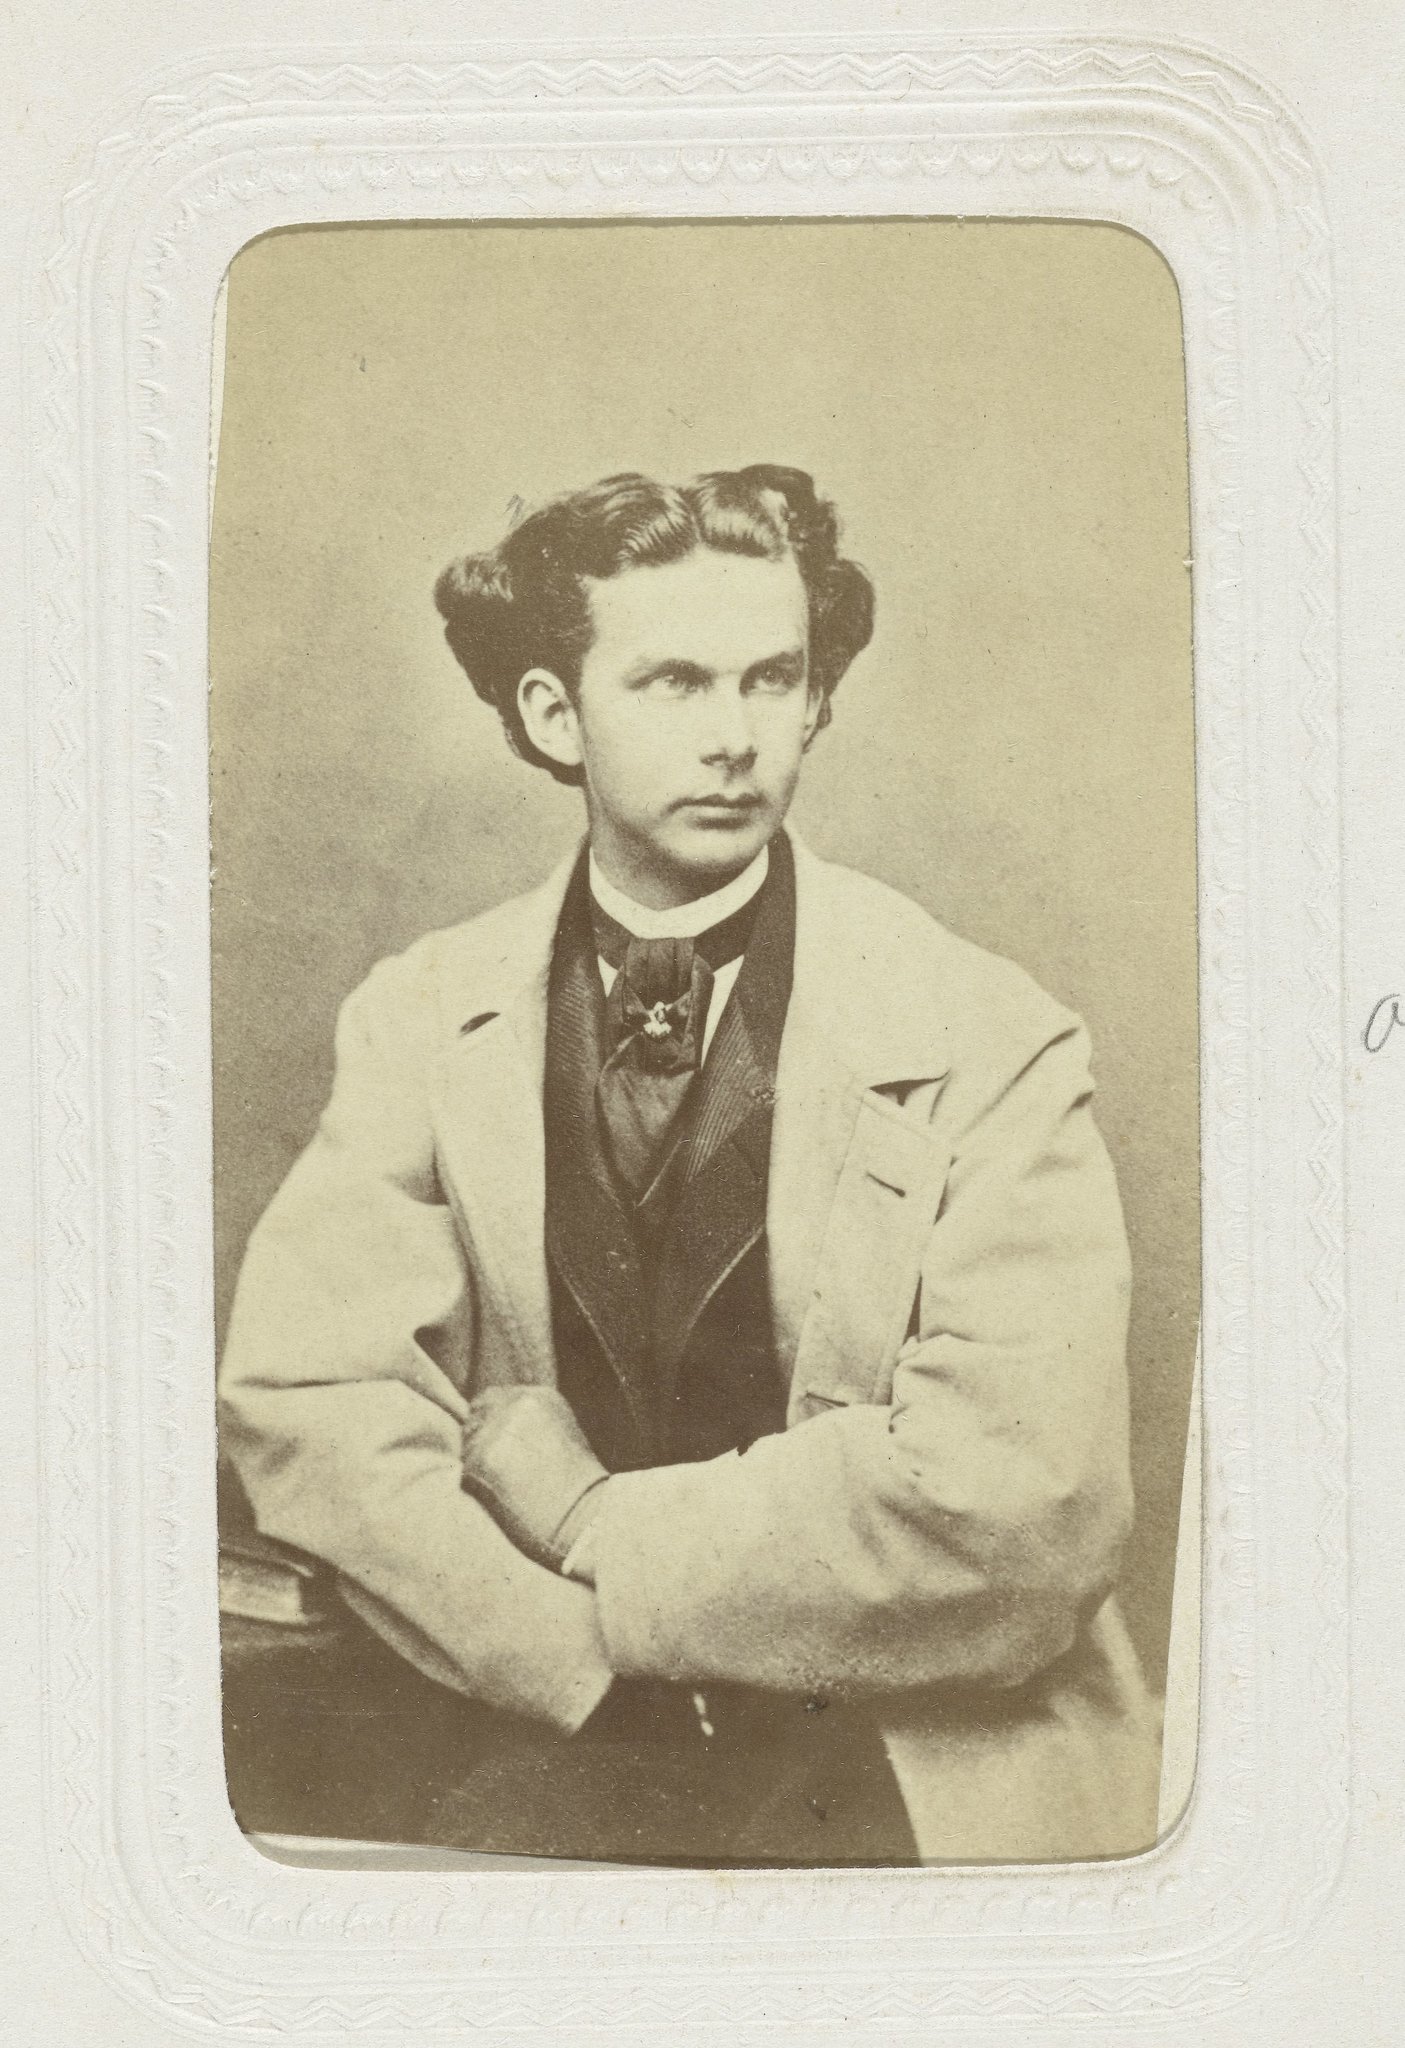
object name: carte de visite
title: Portret van koning Ludwig II van Beieren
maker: Anonymous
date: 1865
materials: cardboard, paper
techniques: albumen print